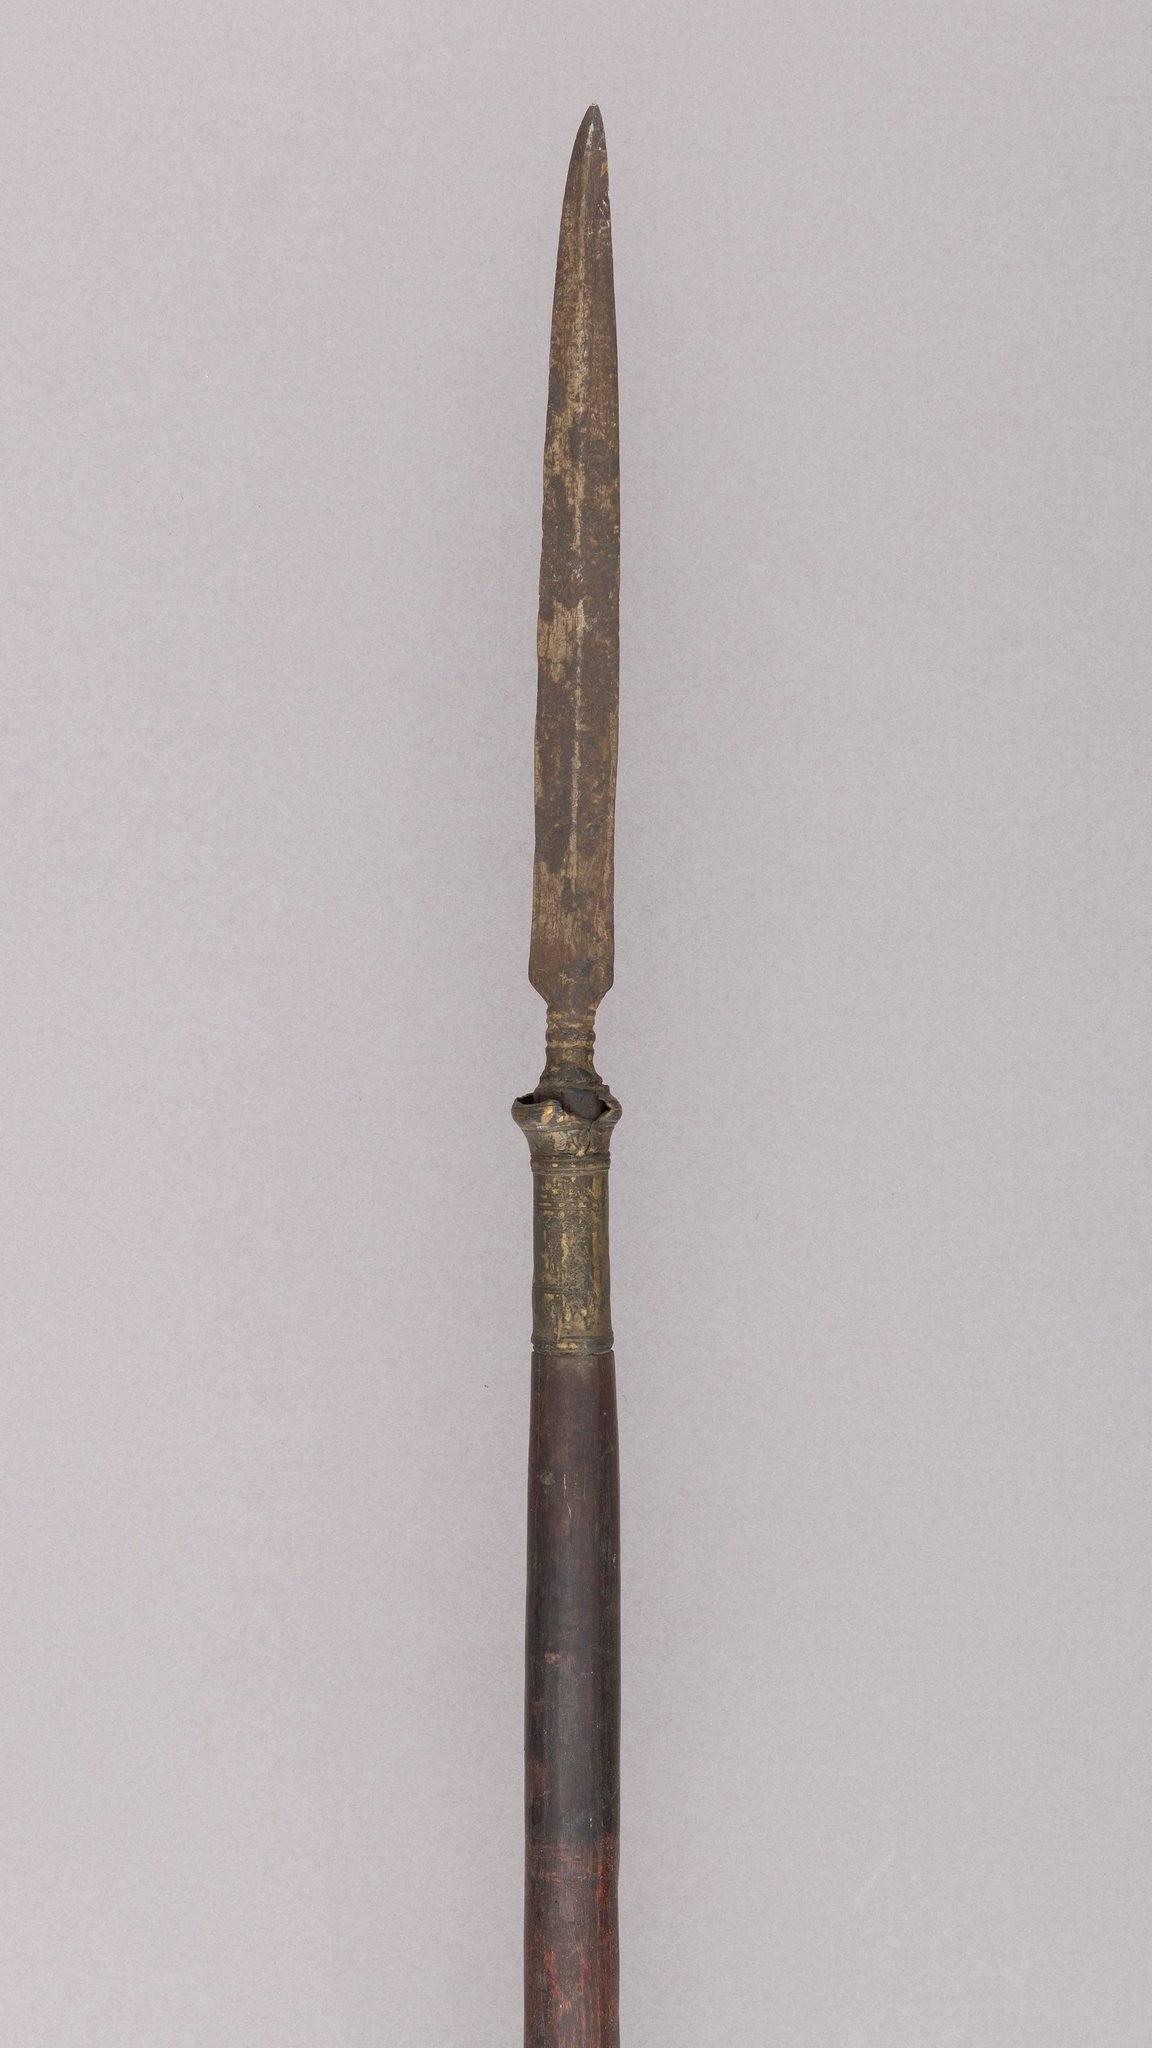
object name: spear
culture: madurese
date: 1701-1900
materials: brass, hair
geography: indonesia